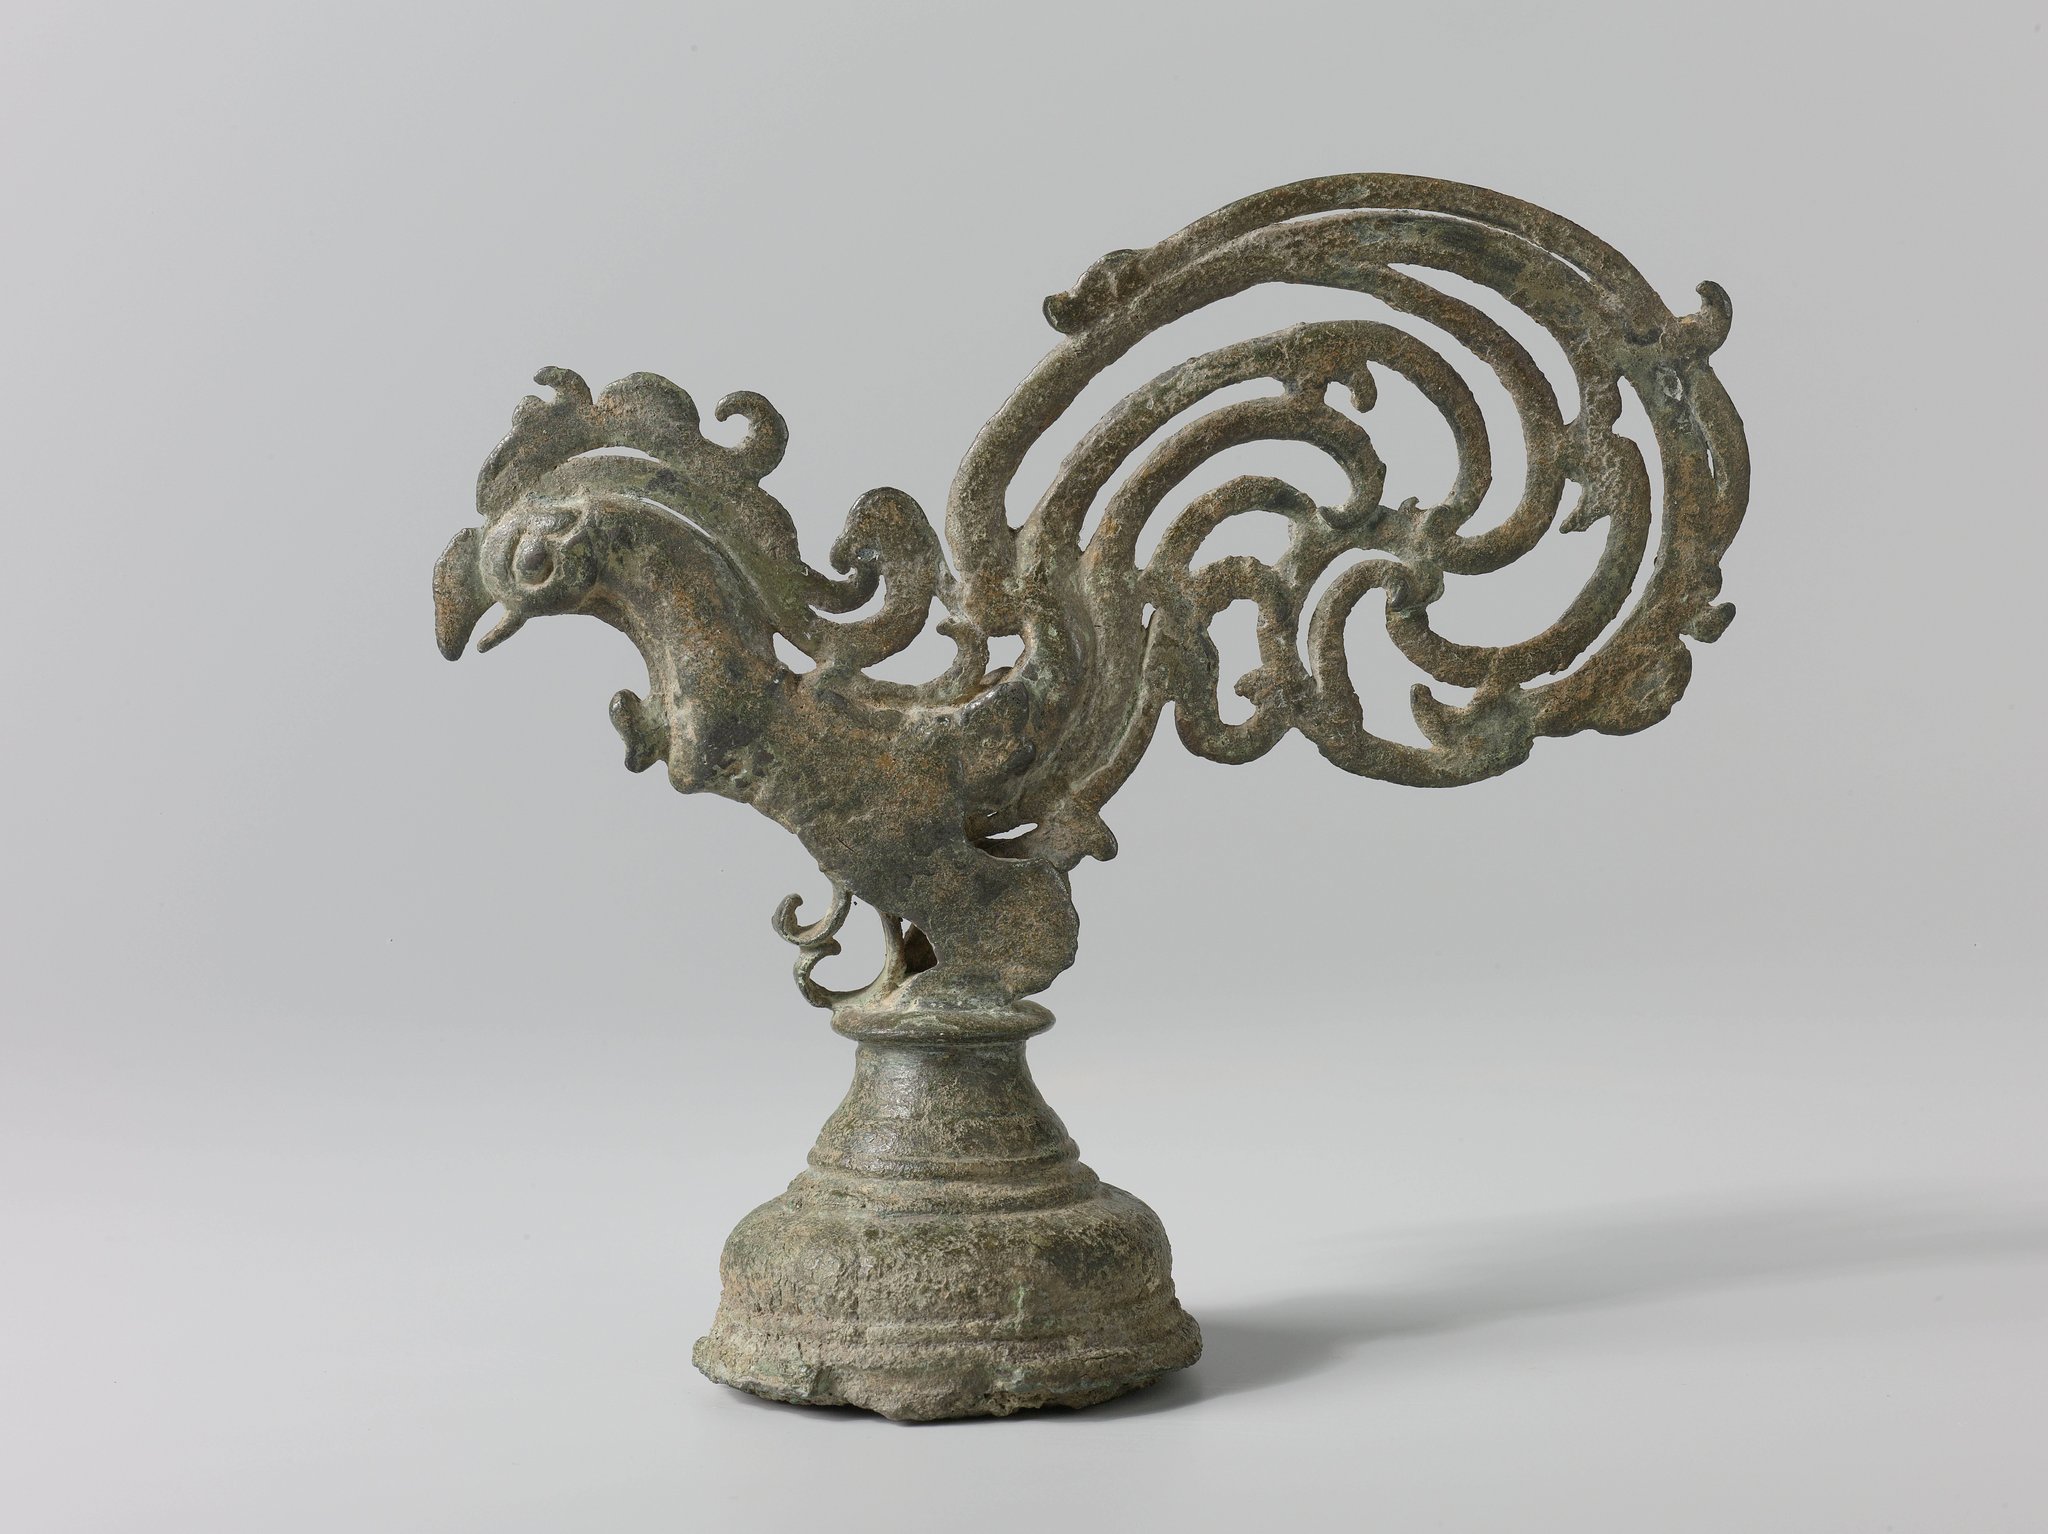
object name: sierstuk, sierobject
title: Bird with exuberant curls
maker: Anonymous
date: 800-1000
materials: bronze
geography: java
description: Bekroning in de vorm van een vogel met krulstaart.